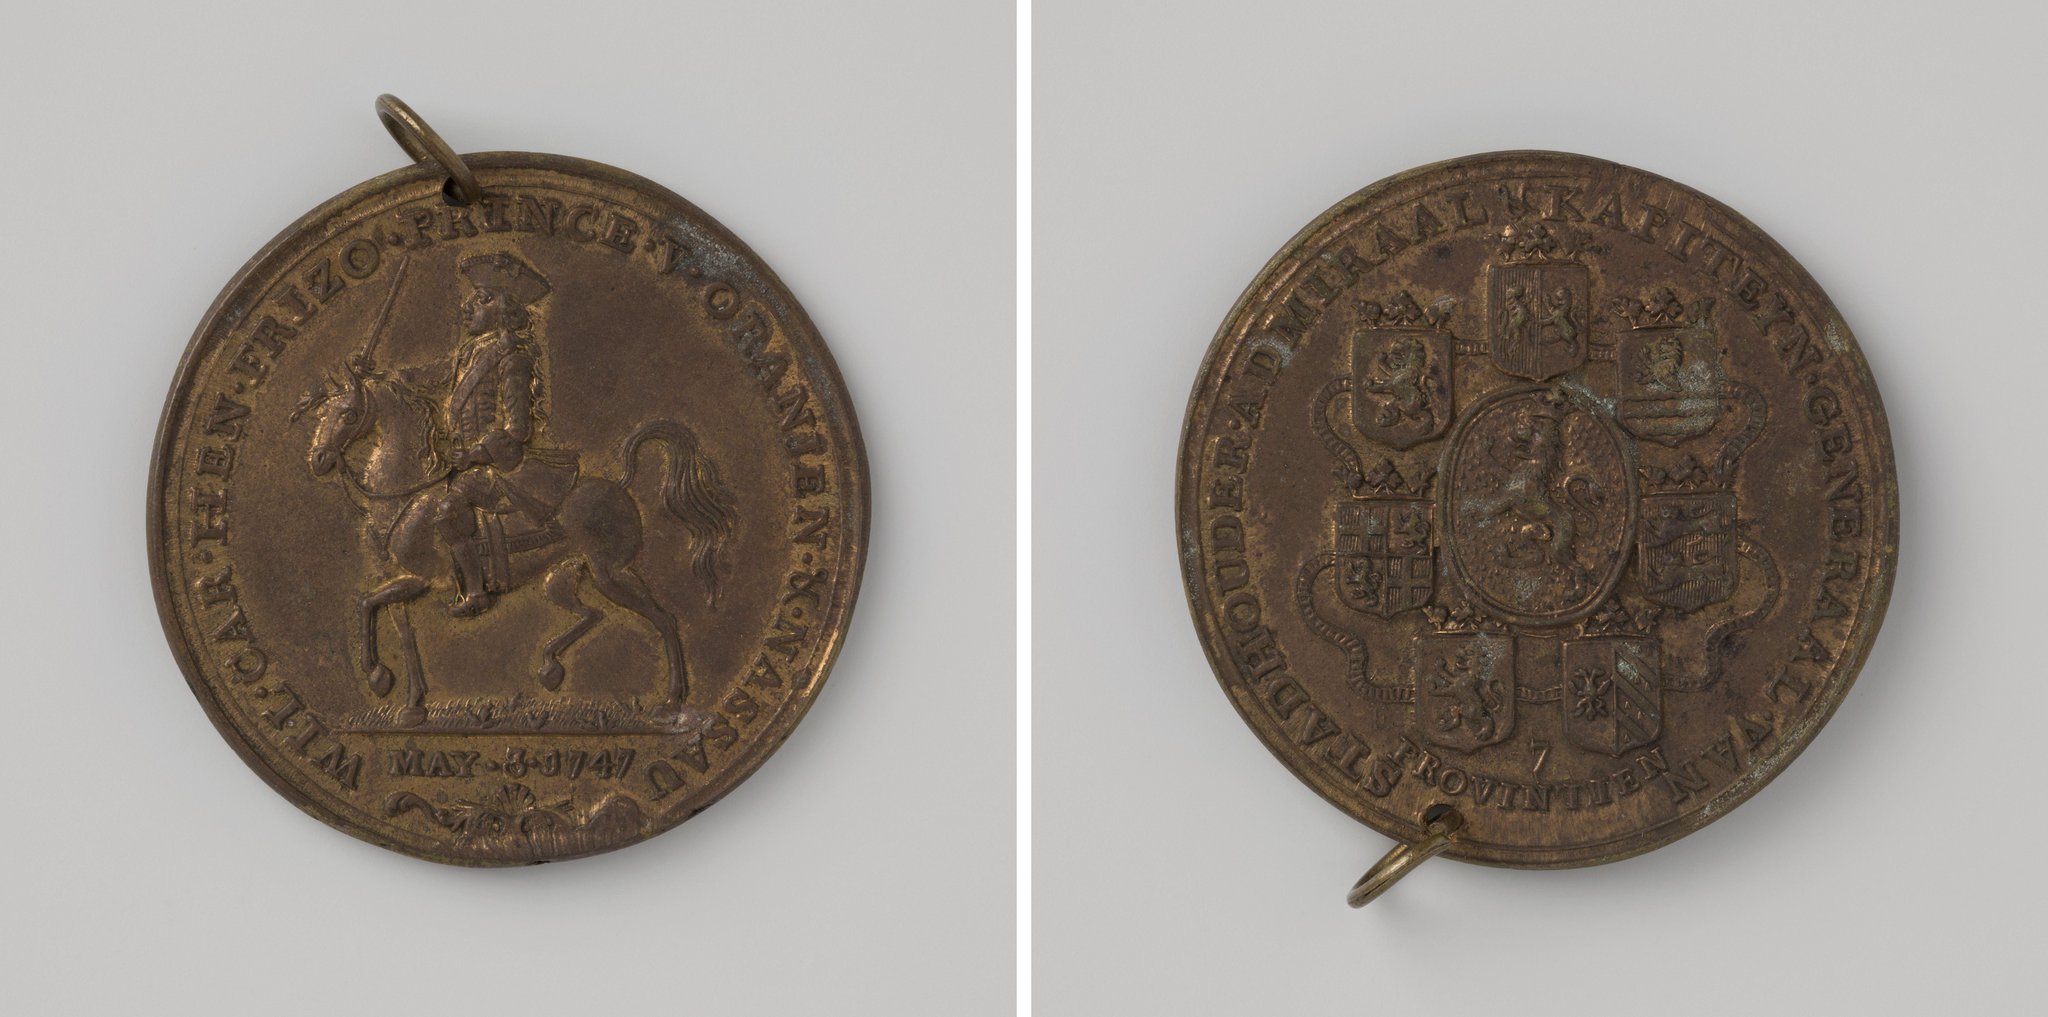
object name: history medal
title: Verheffing van Willem Karel Hendrik Friso van Oranje tot stadhouder 1747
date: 1747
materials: brass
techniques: striking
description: Verguld messing penning met gat en draagring, op de voorzijde Willem te paard met getrokken sabel, met omschrift en afsnedetekst, op de keerzijde, rond een ovaal schild met een gekroonde leeuw, zeven provinciale wapenschilden door een lint verbonden boven de tekst 7 PROVINCIEN